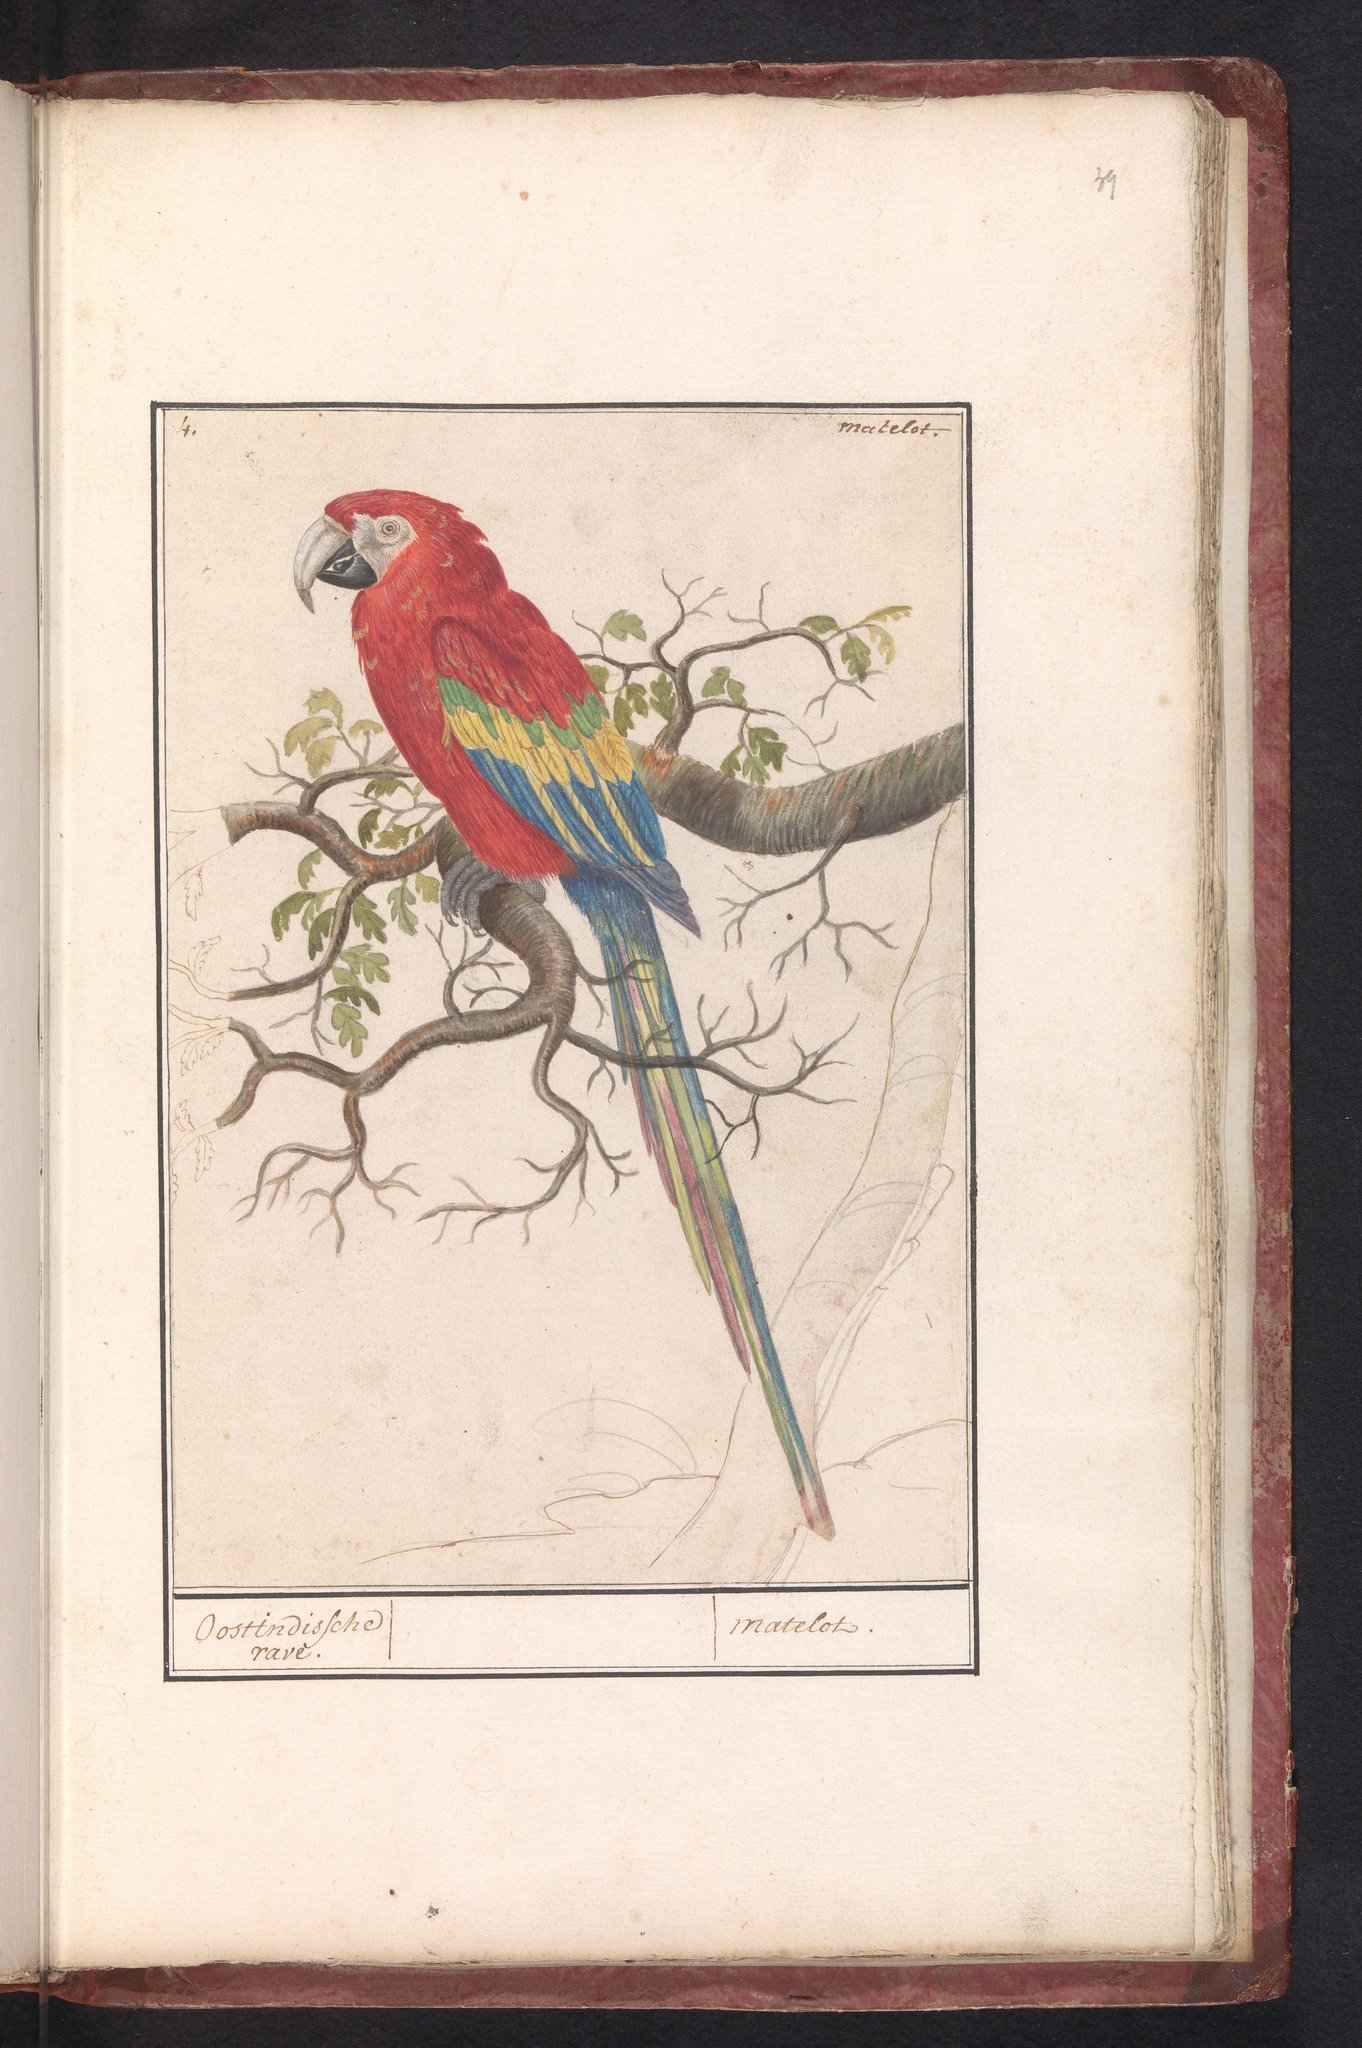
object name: drawing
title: Scarlet Macaw (Ara macao)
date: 1596-1610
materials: paint, ink, paper, pencil, watercolor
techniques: brush, pen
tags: ornamental birds: scarlet macaw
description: The ‘three large books’ assembled by De Boodt must have comprised a book each for plants, animals and birds. Many bird studies have a loss at one corner, and damage suffered by that book may have prompted the 18th-century remounting campaign. Here the added setting is still unfinished, and the Latin name for this South American parrot is missing.